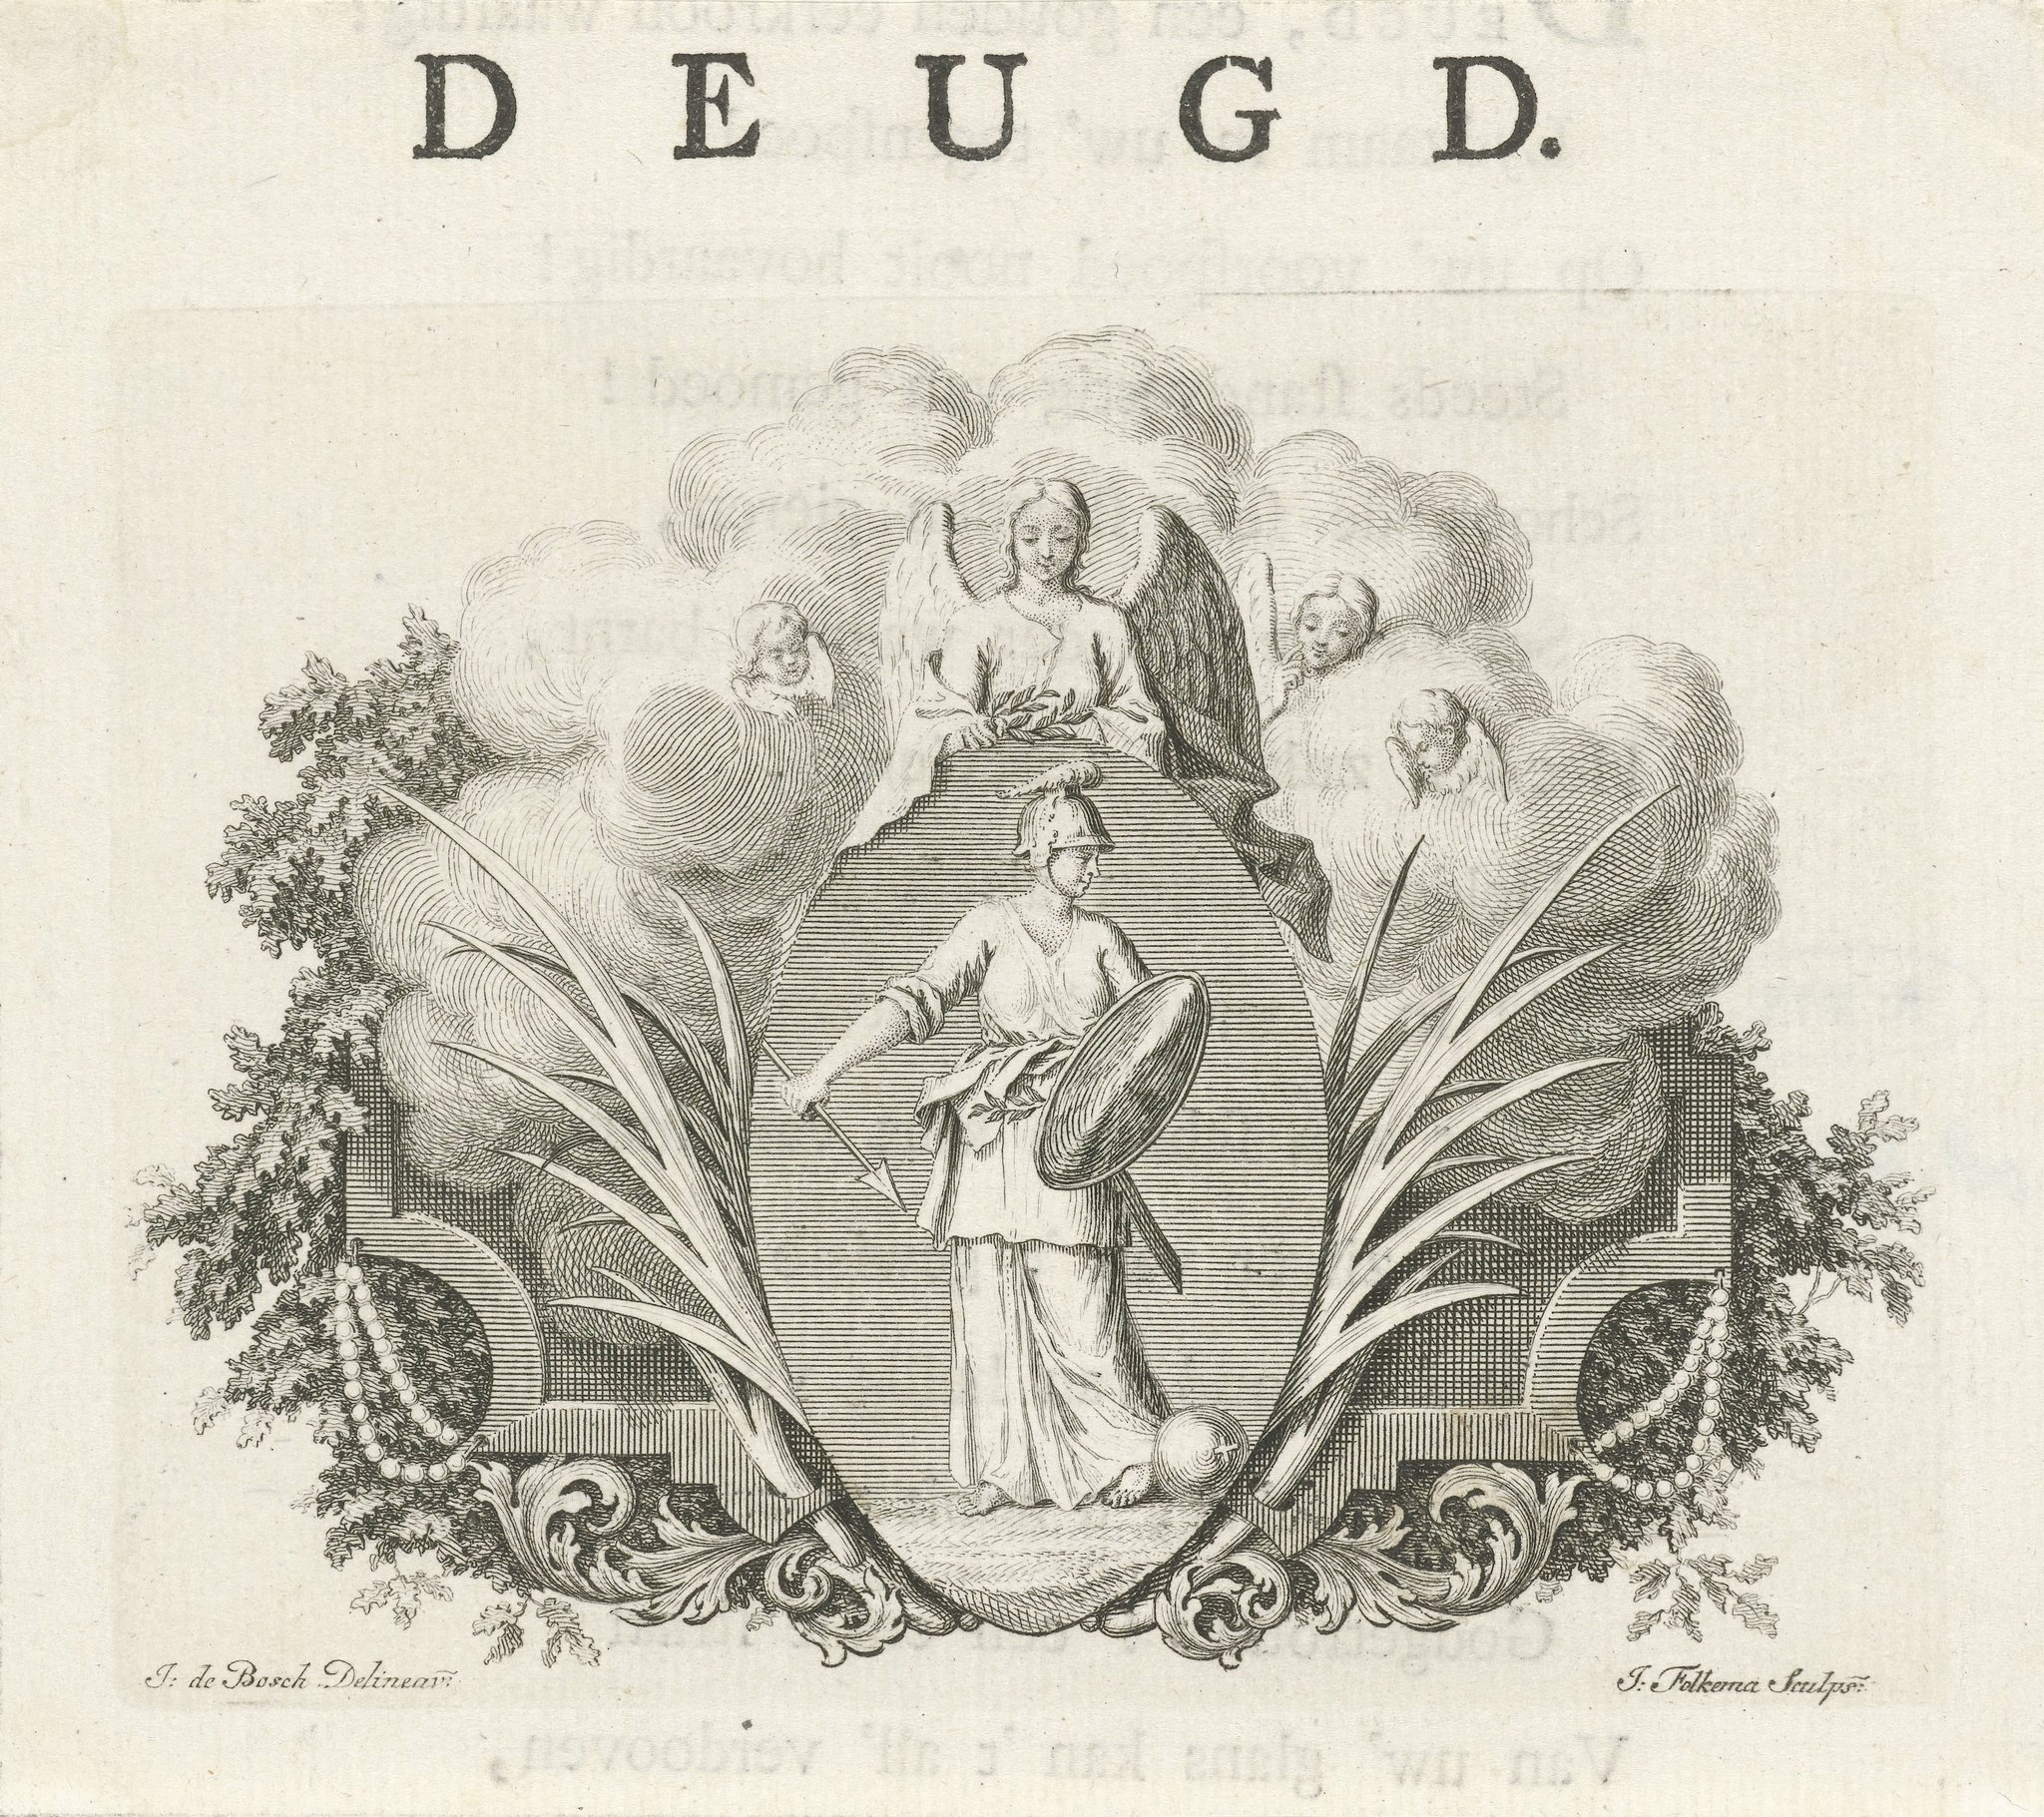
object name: print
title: Vignet met de personificatie van Deugd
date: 1723-1767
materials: paper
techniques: etching, letterpress printing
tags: virtuousness; 'amor di virtù', 'attione virtuosa', 'guida sicura de' veri honori', 'virtù', 'virtù insuperabile' (ripa)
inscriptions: collector's mark: Lugt 2228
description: Vignet met de beeltenis van de gepersonifieerde Deugd in een ovaal dat omgeven wordt door palmtakken en engelen. De Deugd is uitgerust met een helm, schild en zwaard en wordt door een engel gelauwerd. In haar rechterhand houdt de Deugd een pijl vast, bij haar voet ligt een rijksappel. De prent maakt deel uit van een reeks boekillustraties over deugden en ondeugden.